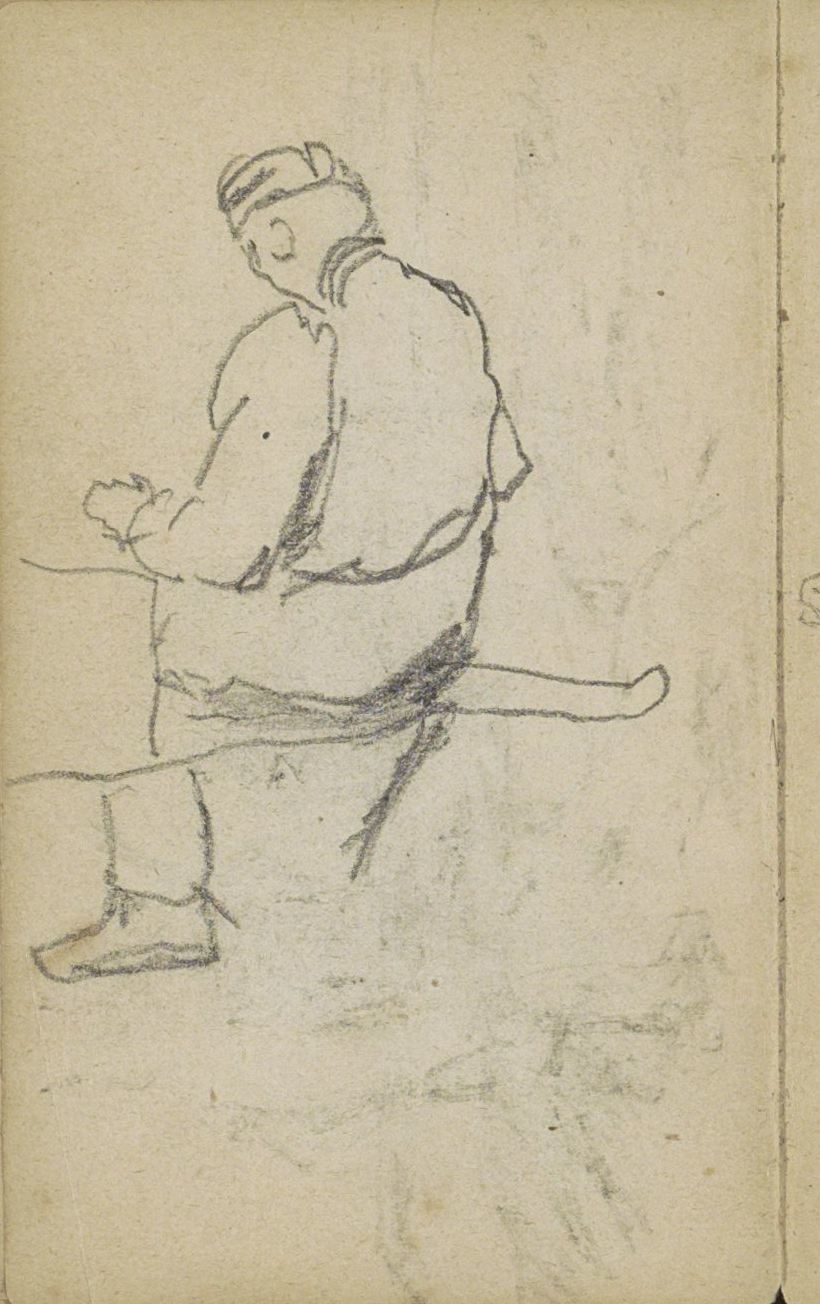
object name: sketchbook leaf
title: Zittende man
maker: johan hendrik weissenbruch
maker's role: draughtsman, painter, print maker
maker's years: 1824-1903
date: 1834-1903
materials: paper, pencil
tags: sitting figure (+ adult male (human being))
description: Blad 8 verso uit een schetsboek met 32 bladen.